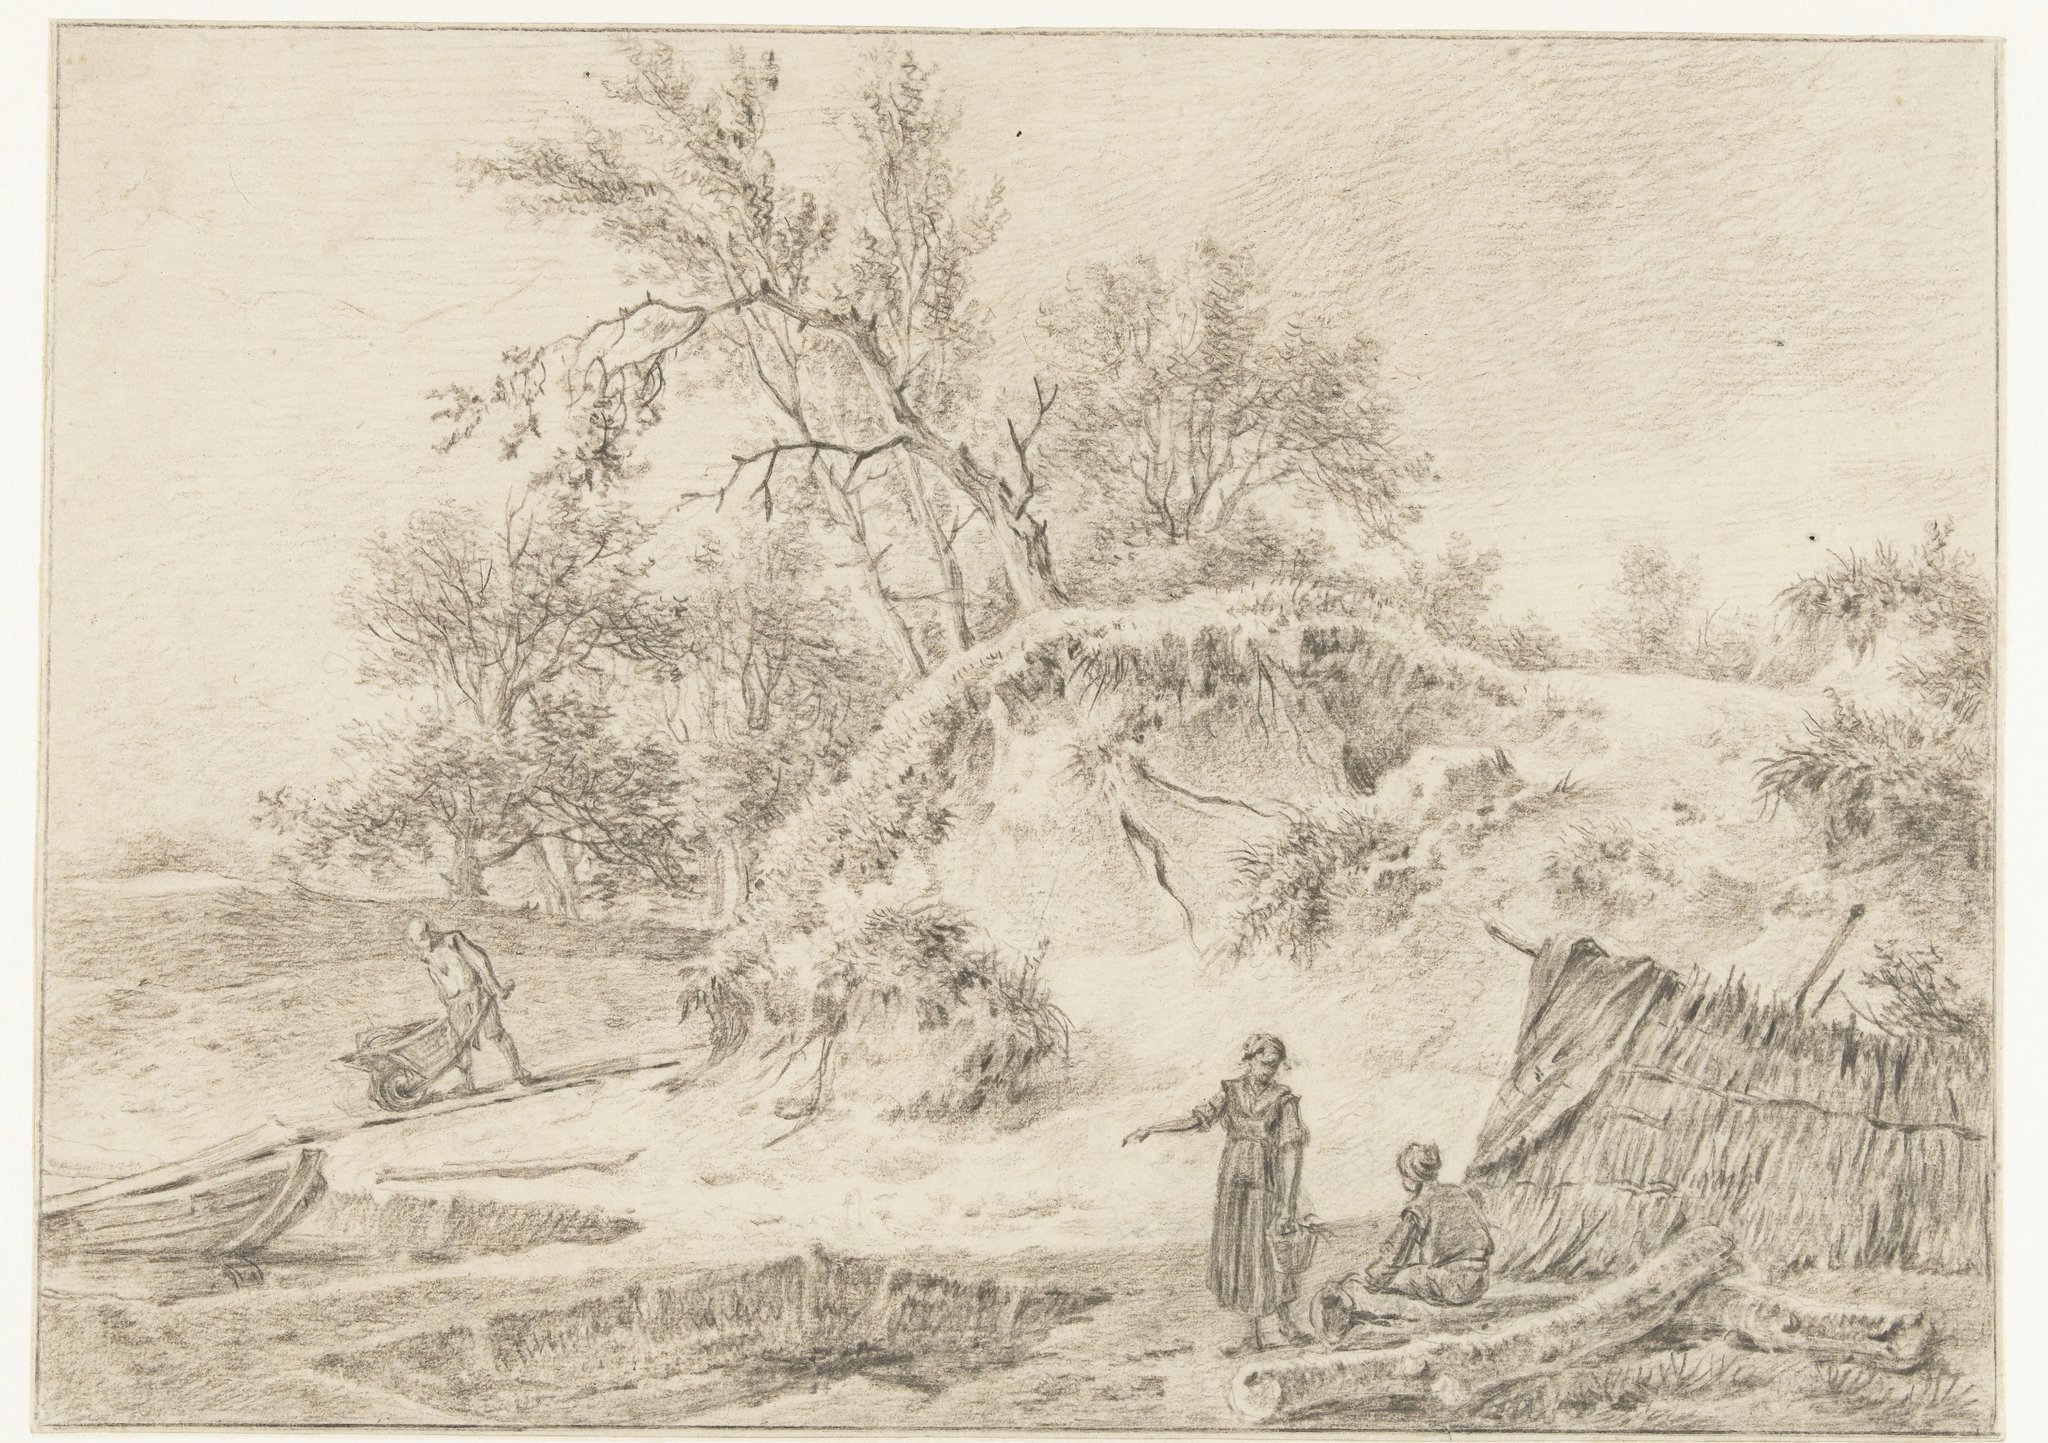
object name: drawing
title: De Zanderij van de Heer Hoopen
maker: pieter pietersz. barbiers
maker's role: draughtsman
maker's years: 1749-1842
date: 1759-1842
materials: chalk, paper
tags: dunes (sea not visible); in the dunes, haarlem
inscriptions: : ‘De Zanderij van de Heer Hoopen, zeyn Buyteplaas Boove Harelem’